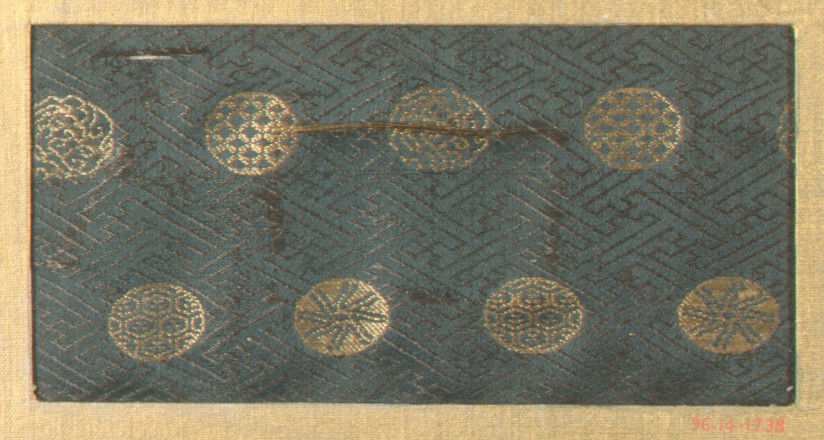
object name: piece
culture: japanese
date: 1701-1900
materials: silk